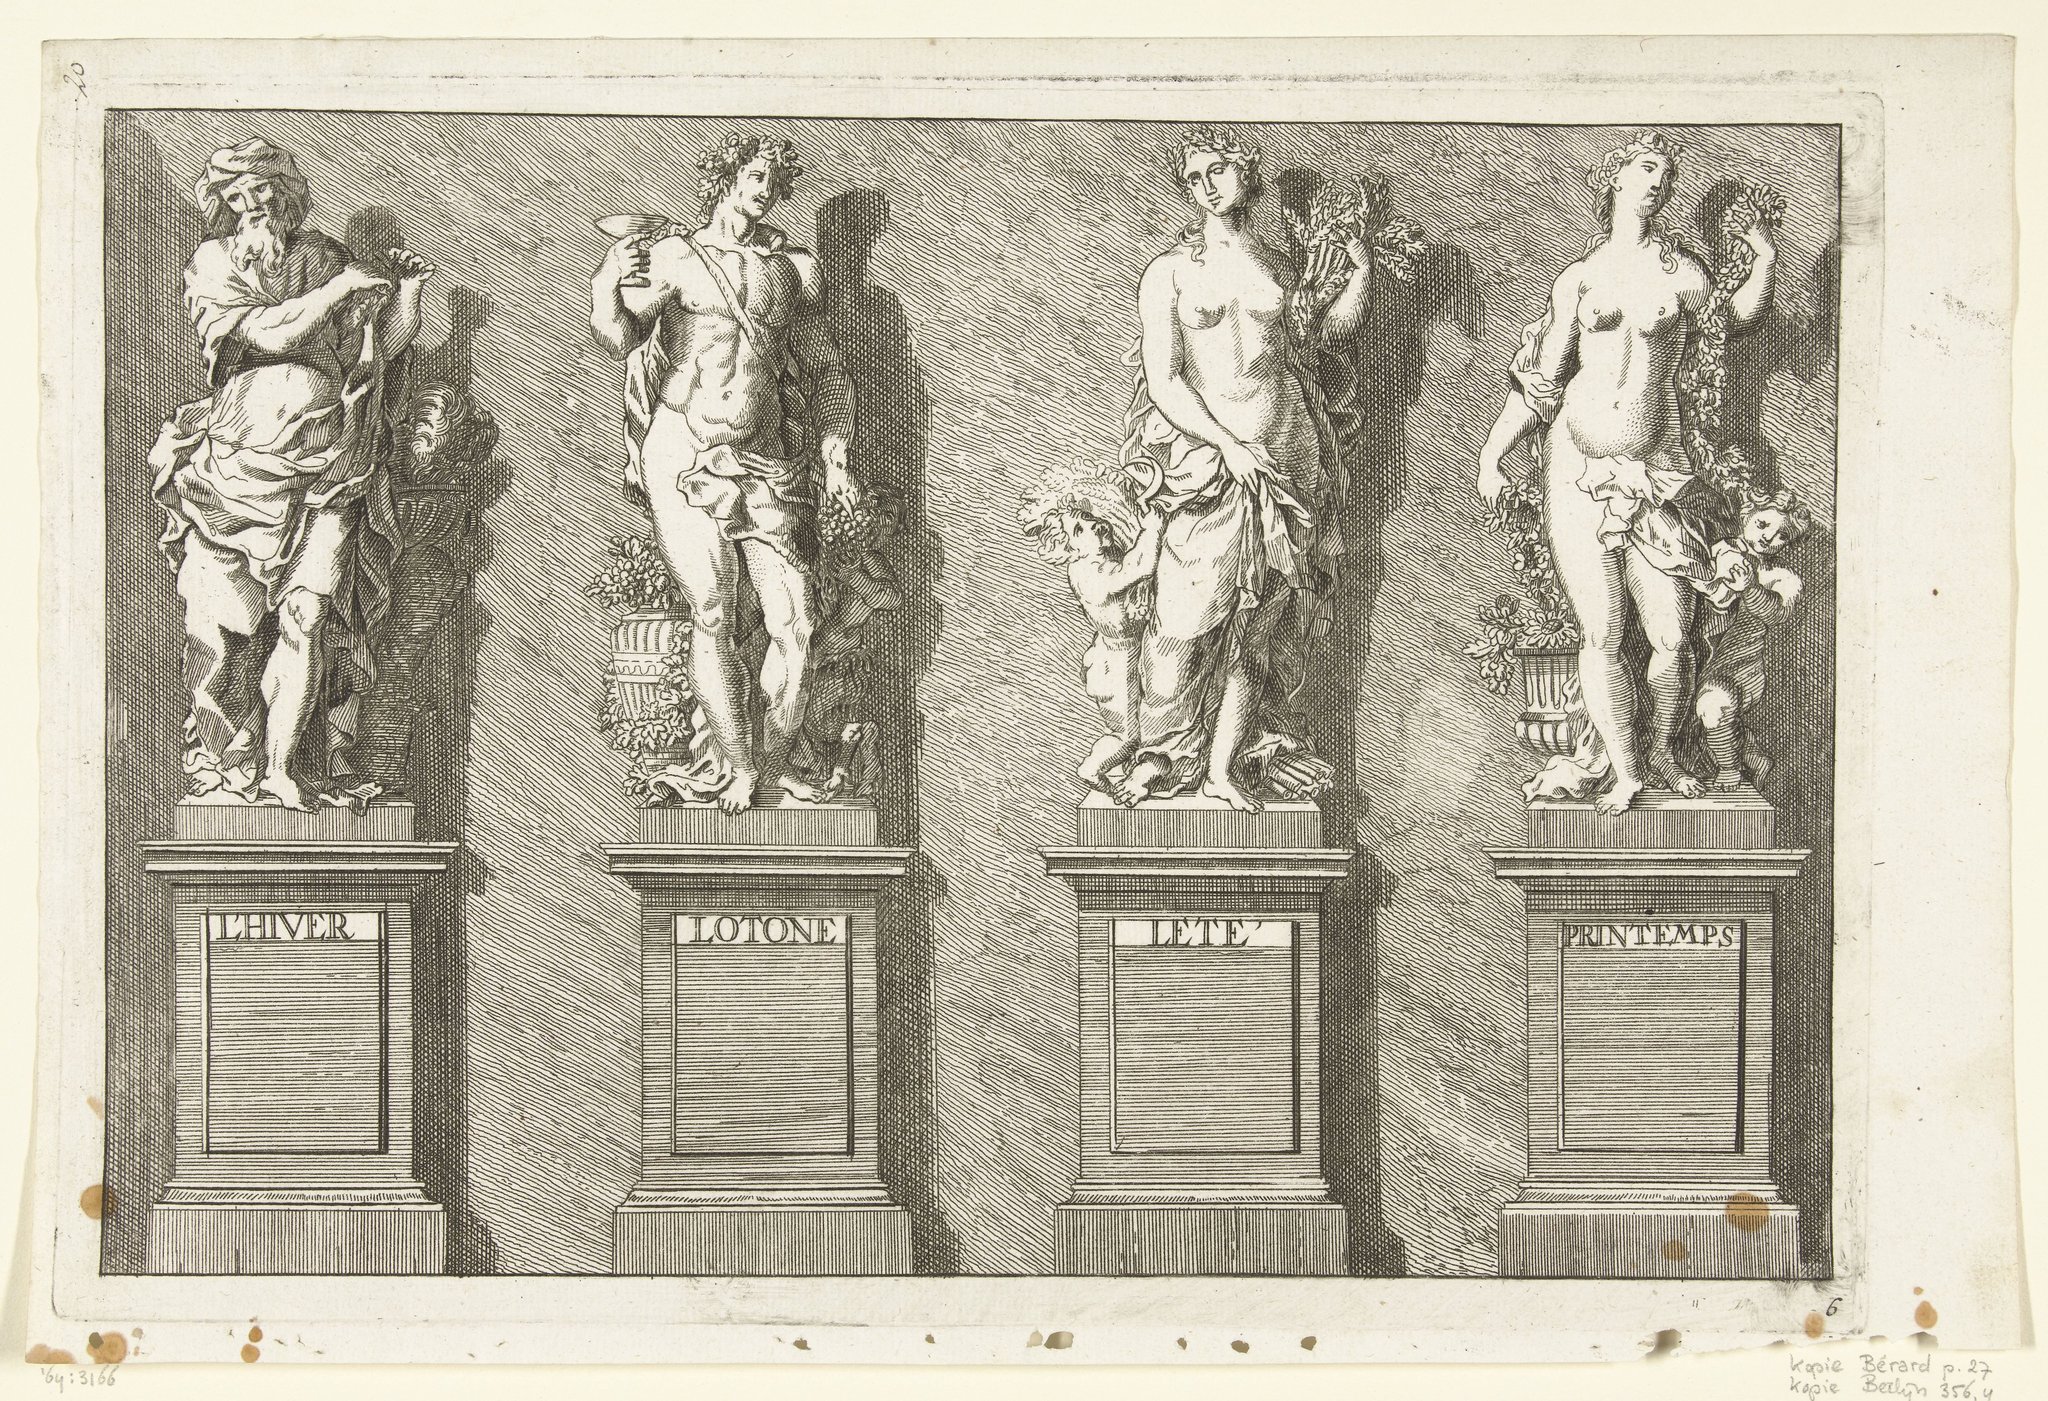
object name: ornament print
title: Vier beelden op sokkels: Winter, Herfst, Zomer, Lente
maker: Anonymous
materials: paper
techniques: etching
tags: summer, 'aestas'; 'estate' (ripa), spring, 'ver'; 'primavera' (ripa), winter, 'hyems'; 'inverno' (ripa), piece of sculpture, reproduction of a piece of sculpture, autumn, fall, 'autumnus'; 'autunno' (ripa), statues, sculptures in garden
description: Vier beelden op voetstukken, met de naam op de sokkel. Kopie naar blad uit serie Liure de Statues uitgegeven door Daniel Marot.